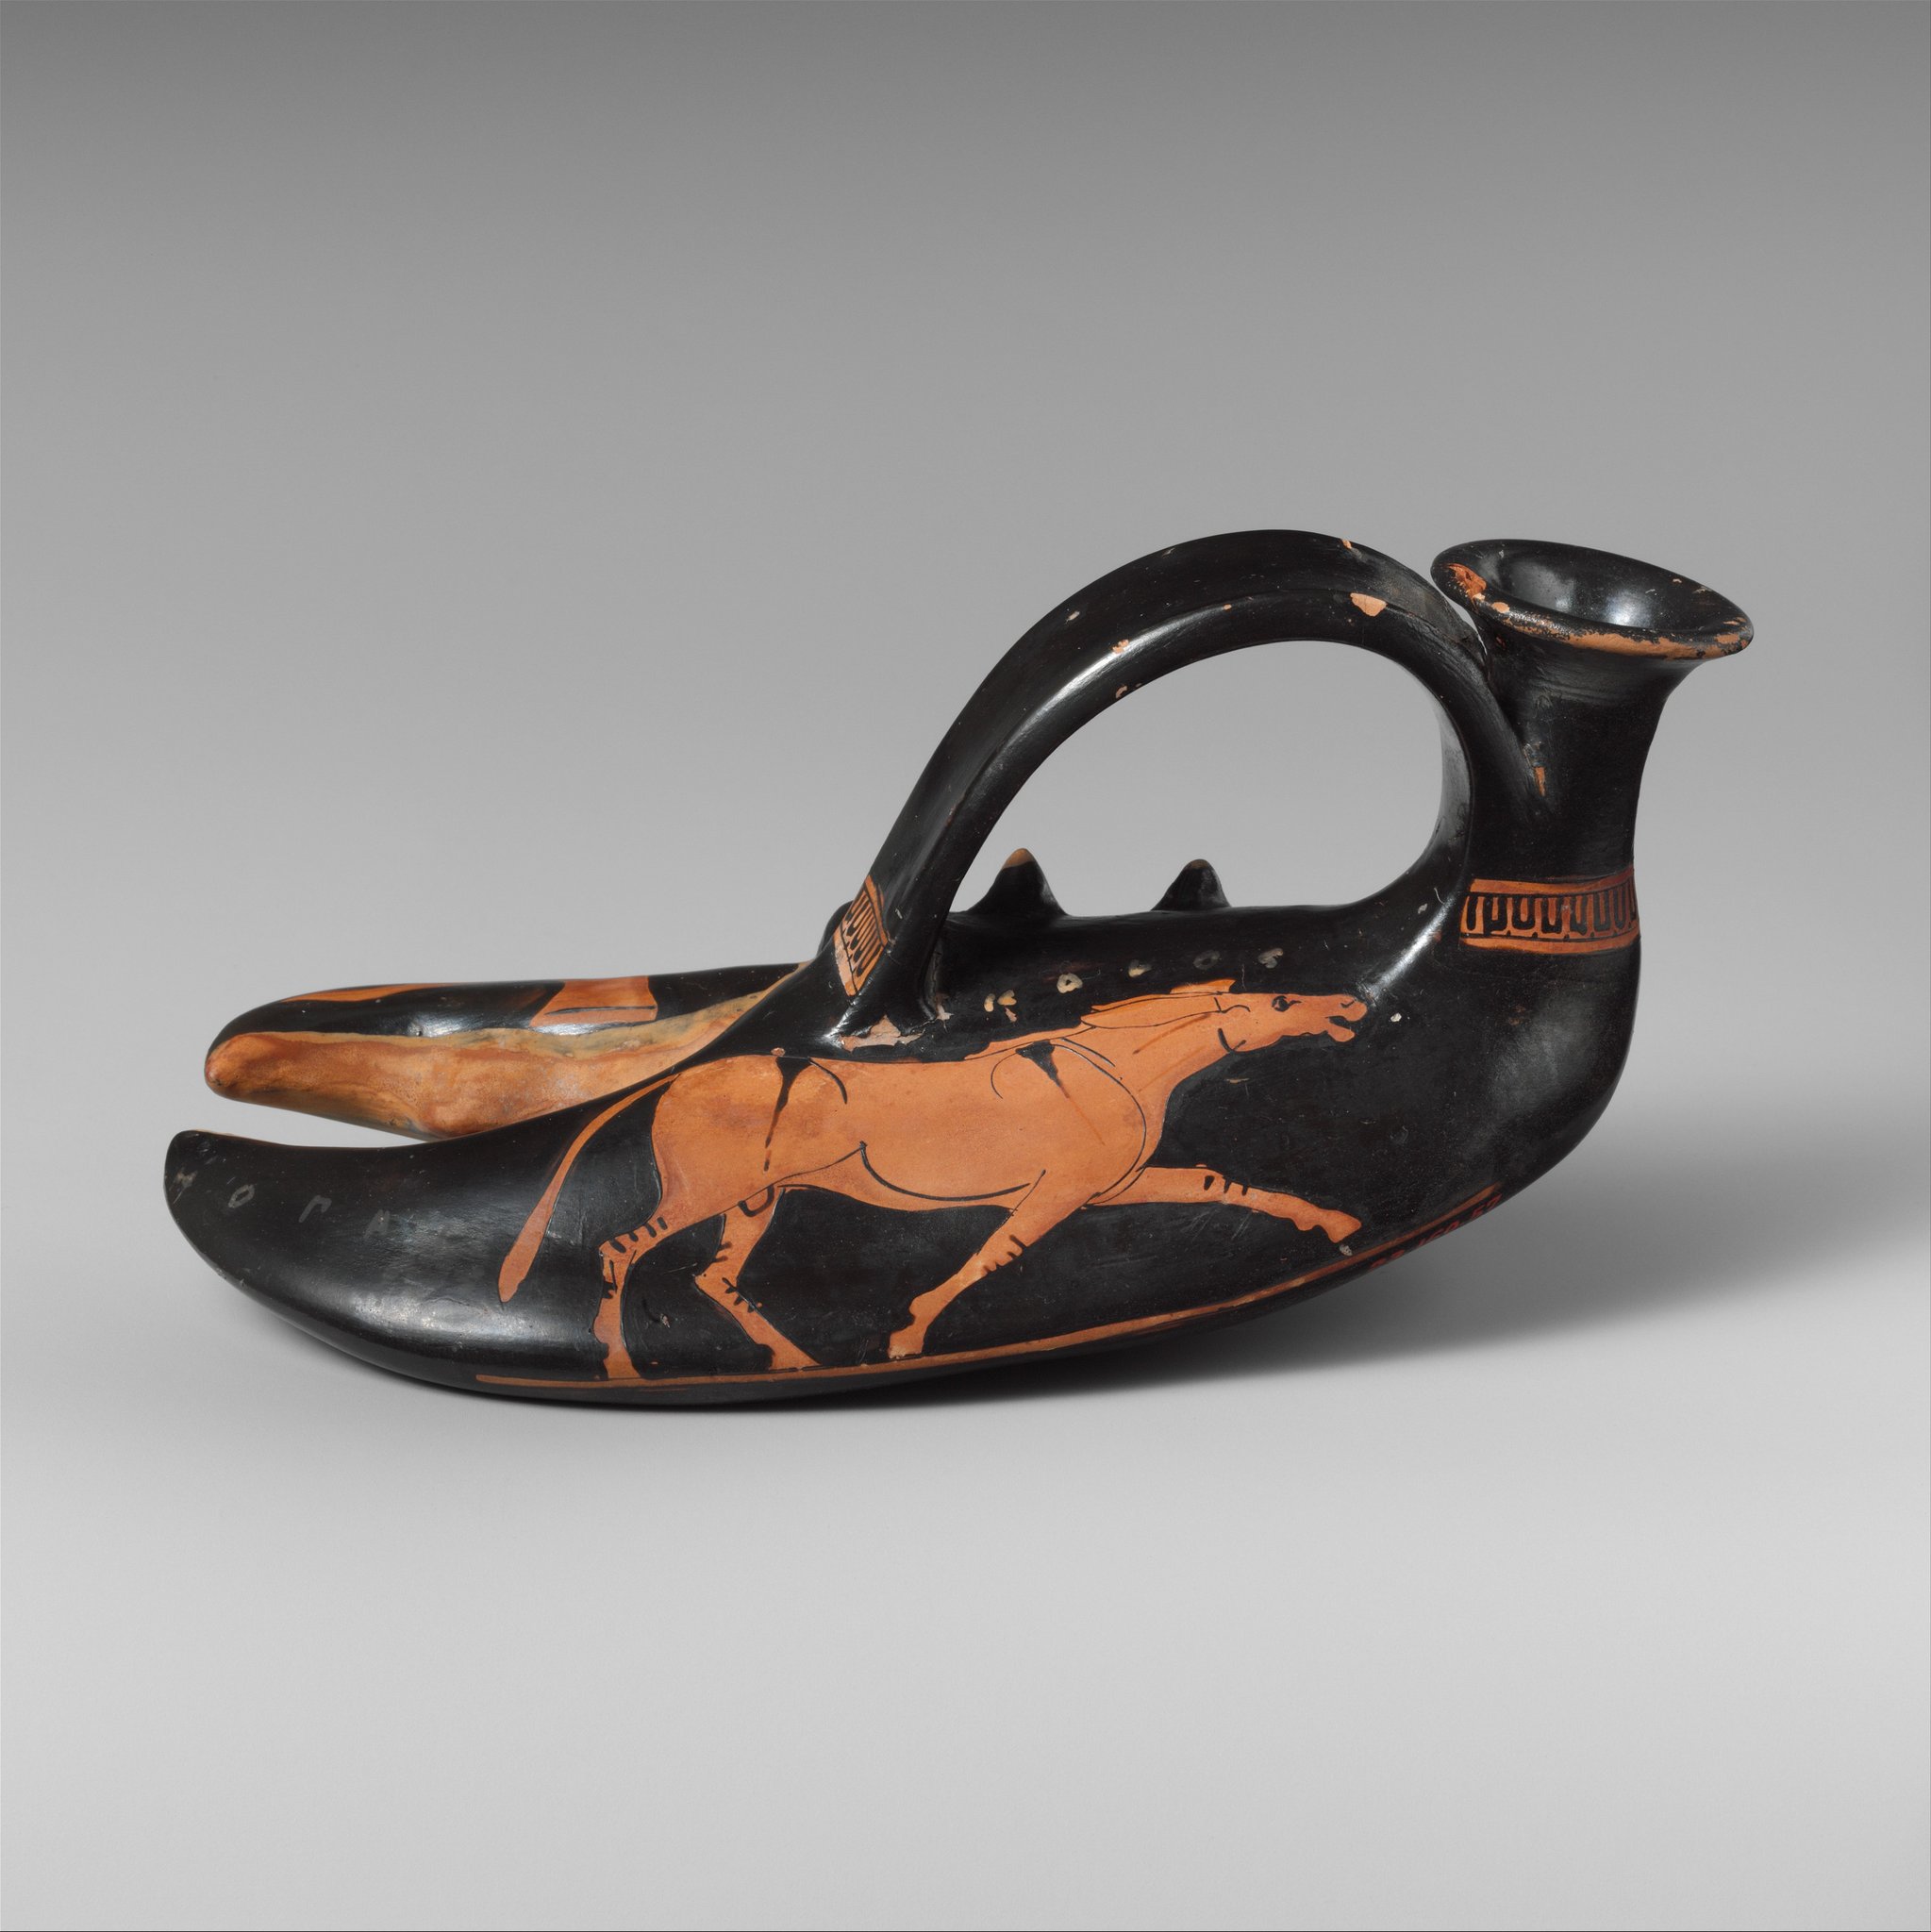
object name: askos in the form of a lobster claw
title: Terracotta vase in the form of a lobster claw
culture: greek, attic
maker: class of seven lobster-claws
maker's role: artist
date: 460 BCE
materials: terracotta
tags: horses,lobsters